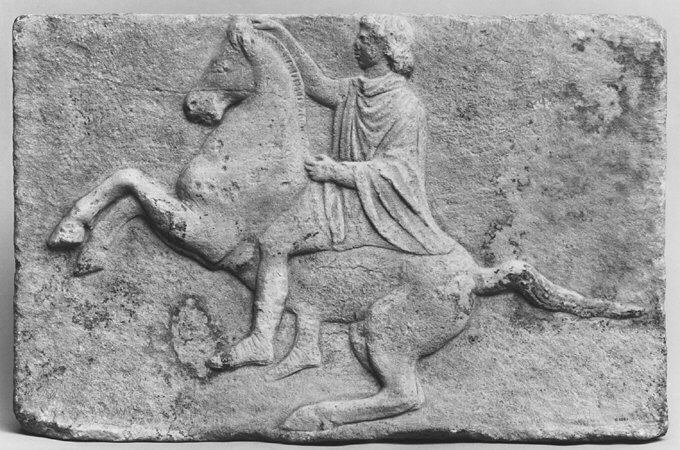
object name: relief of a horseman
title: Marble relief with a horseman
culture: greek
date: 400-301 BCE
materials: marble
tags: men,horses